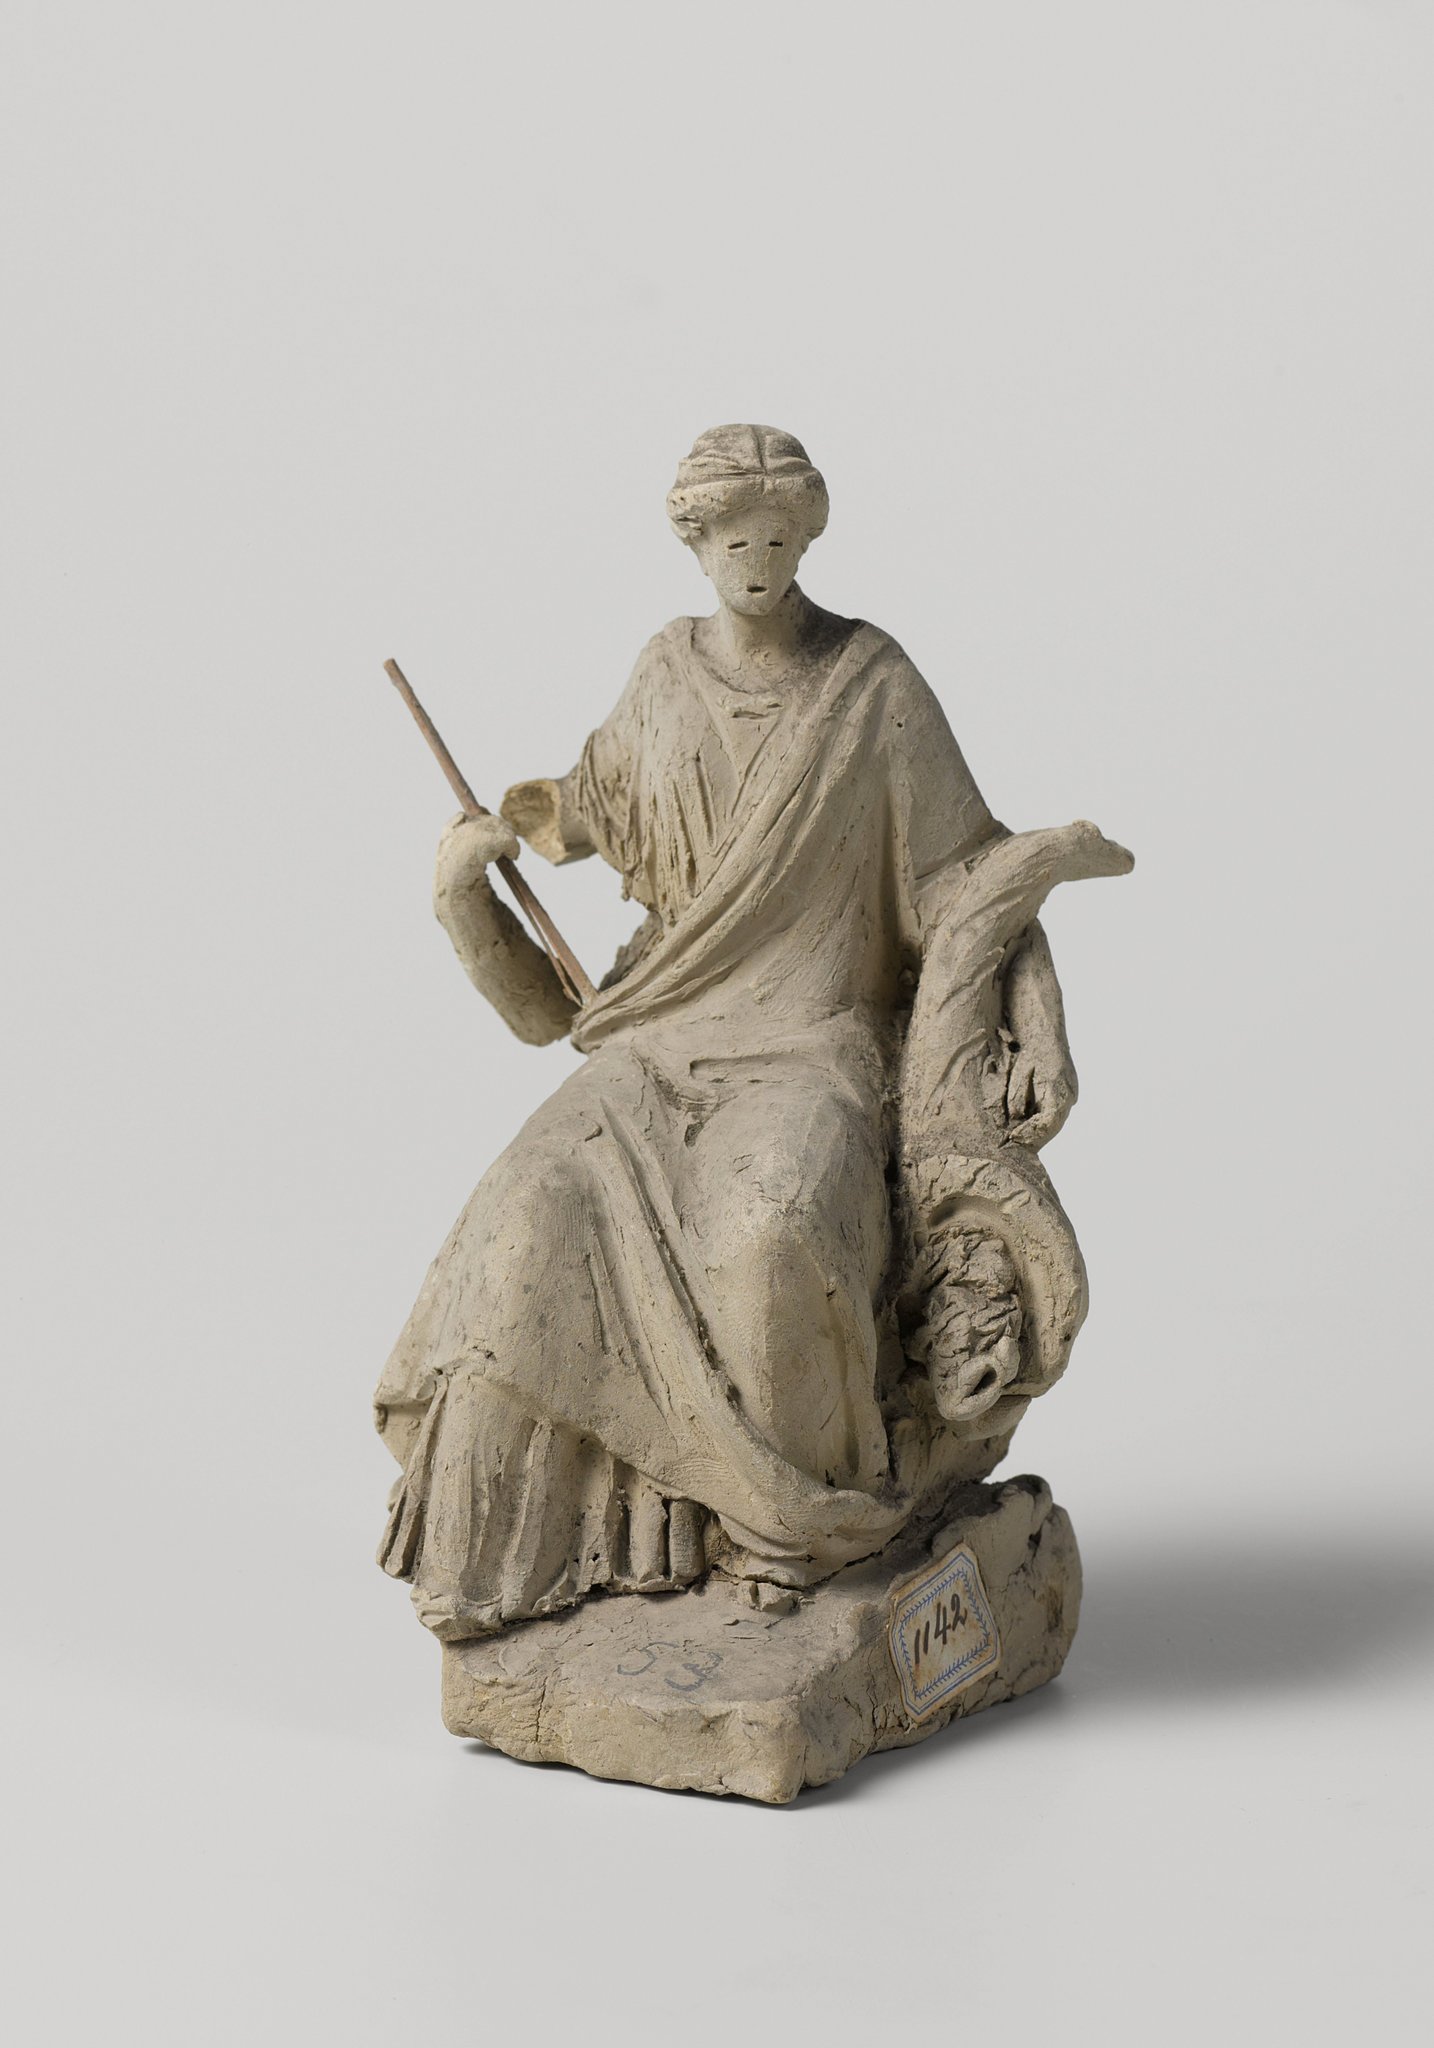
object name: sculpture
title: De Handel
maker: eugène lacomblé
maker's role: draughtsman, painter, sculptor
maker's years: 1828-1905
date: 1800-1900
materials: clay